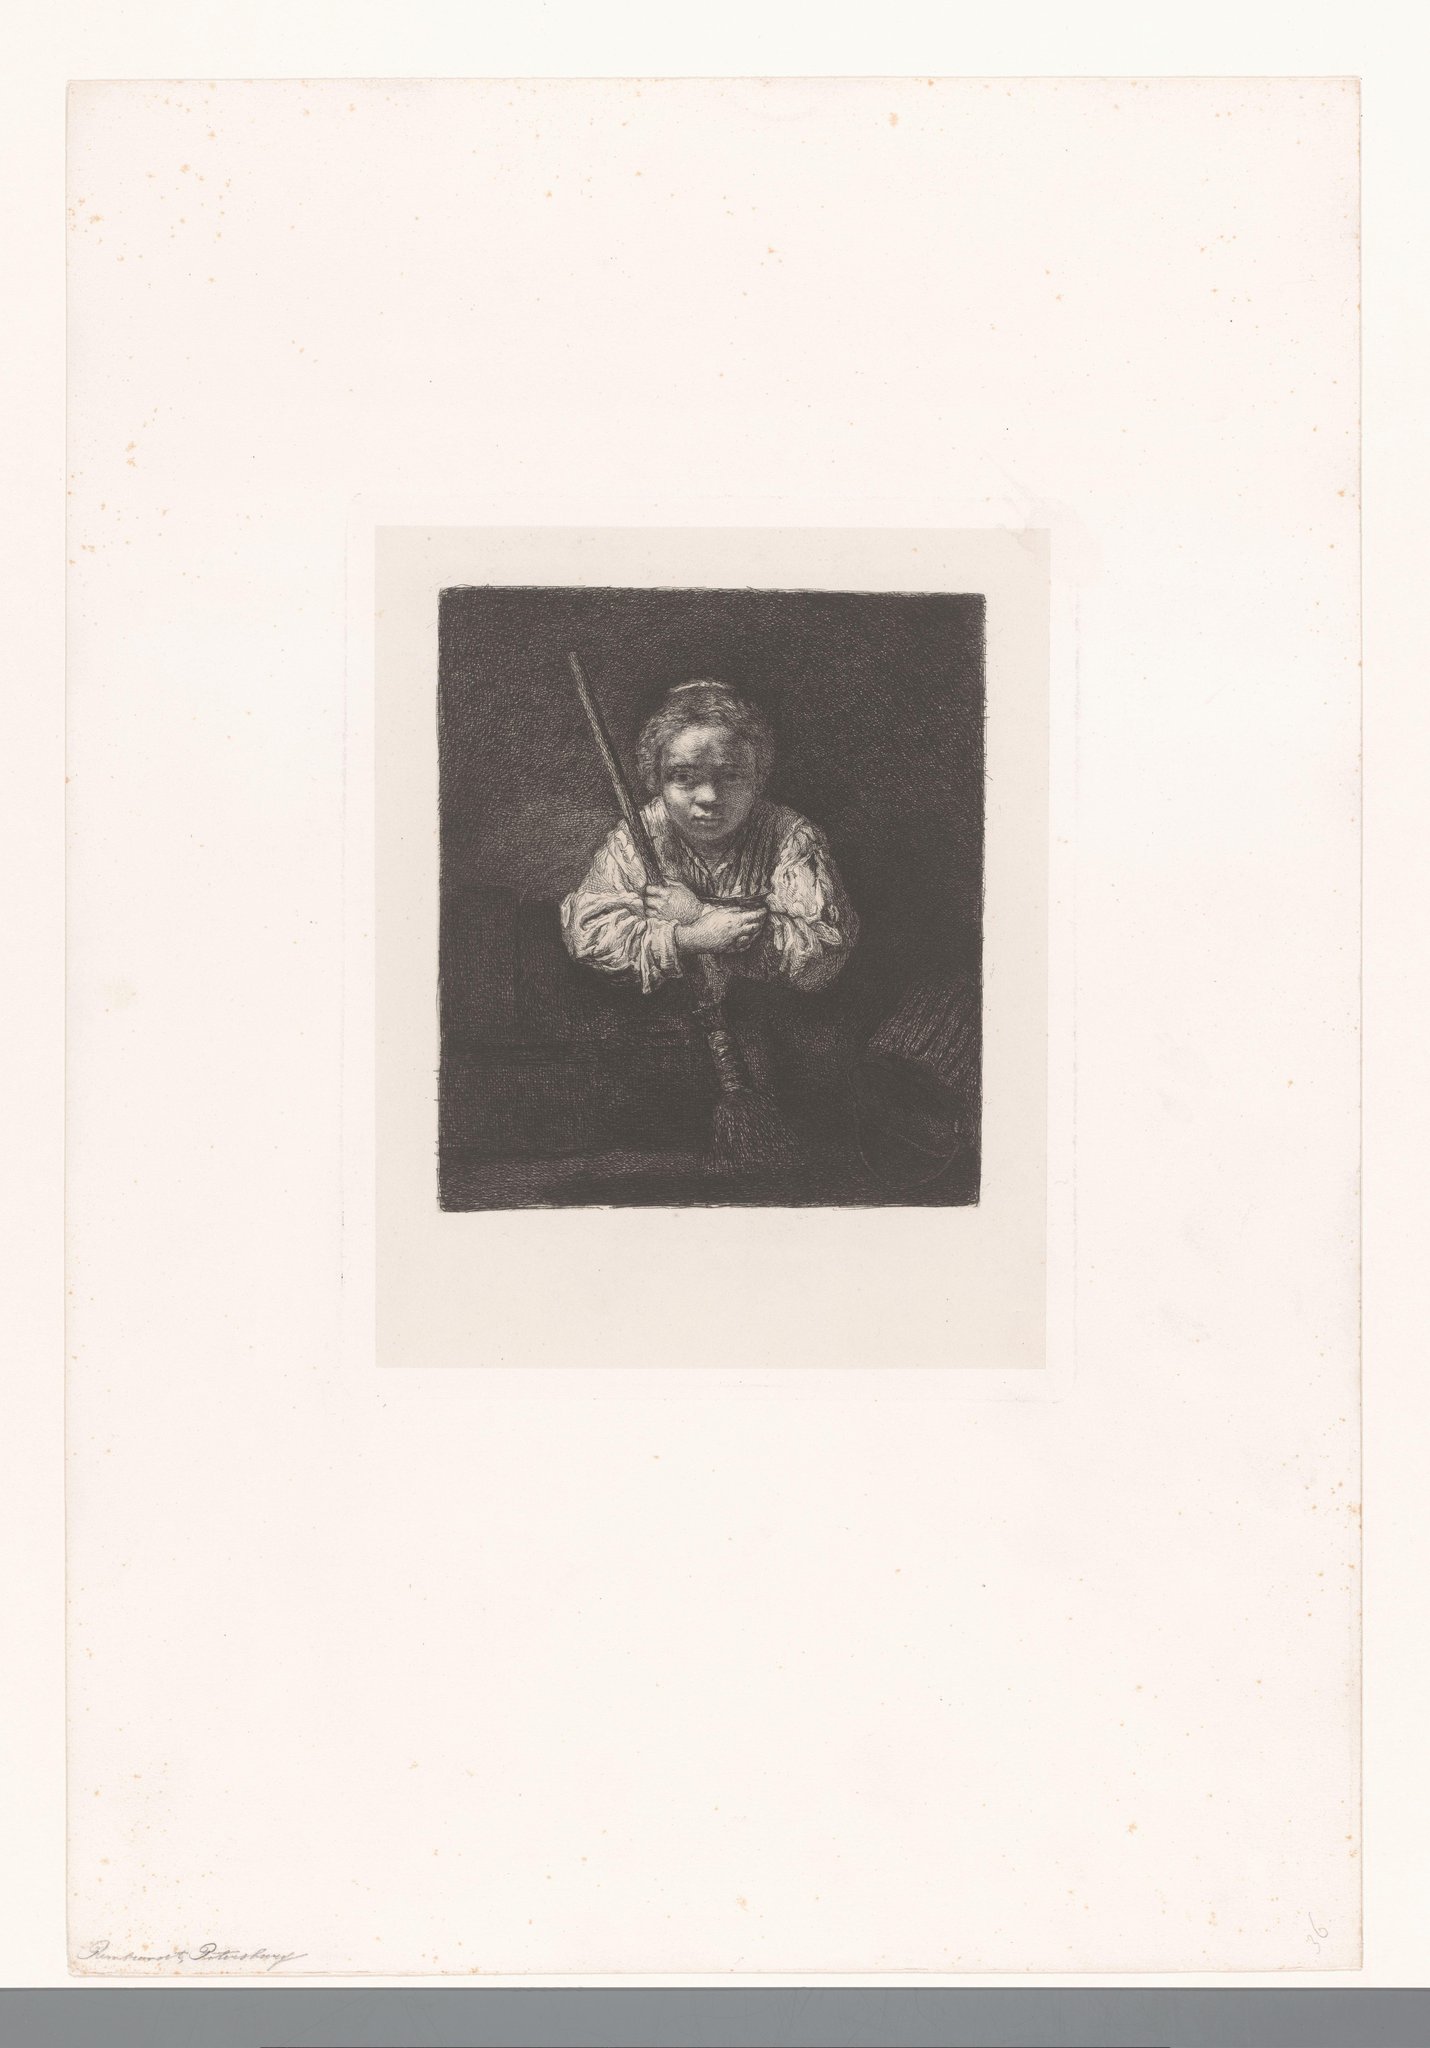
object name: print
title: Meisje leunend op veger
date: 1857-1914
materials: paper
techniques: drypoint, etching, intaglio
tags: girl (child between toddler and youth), (household) utensils and implements (with name)